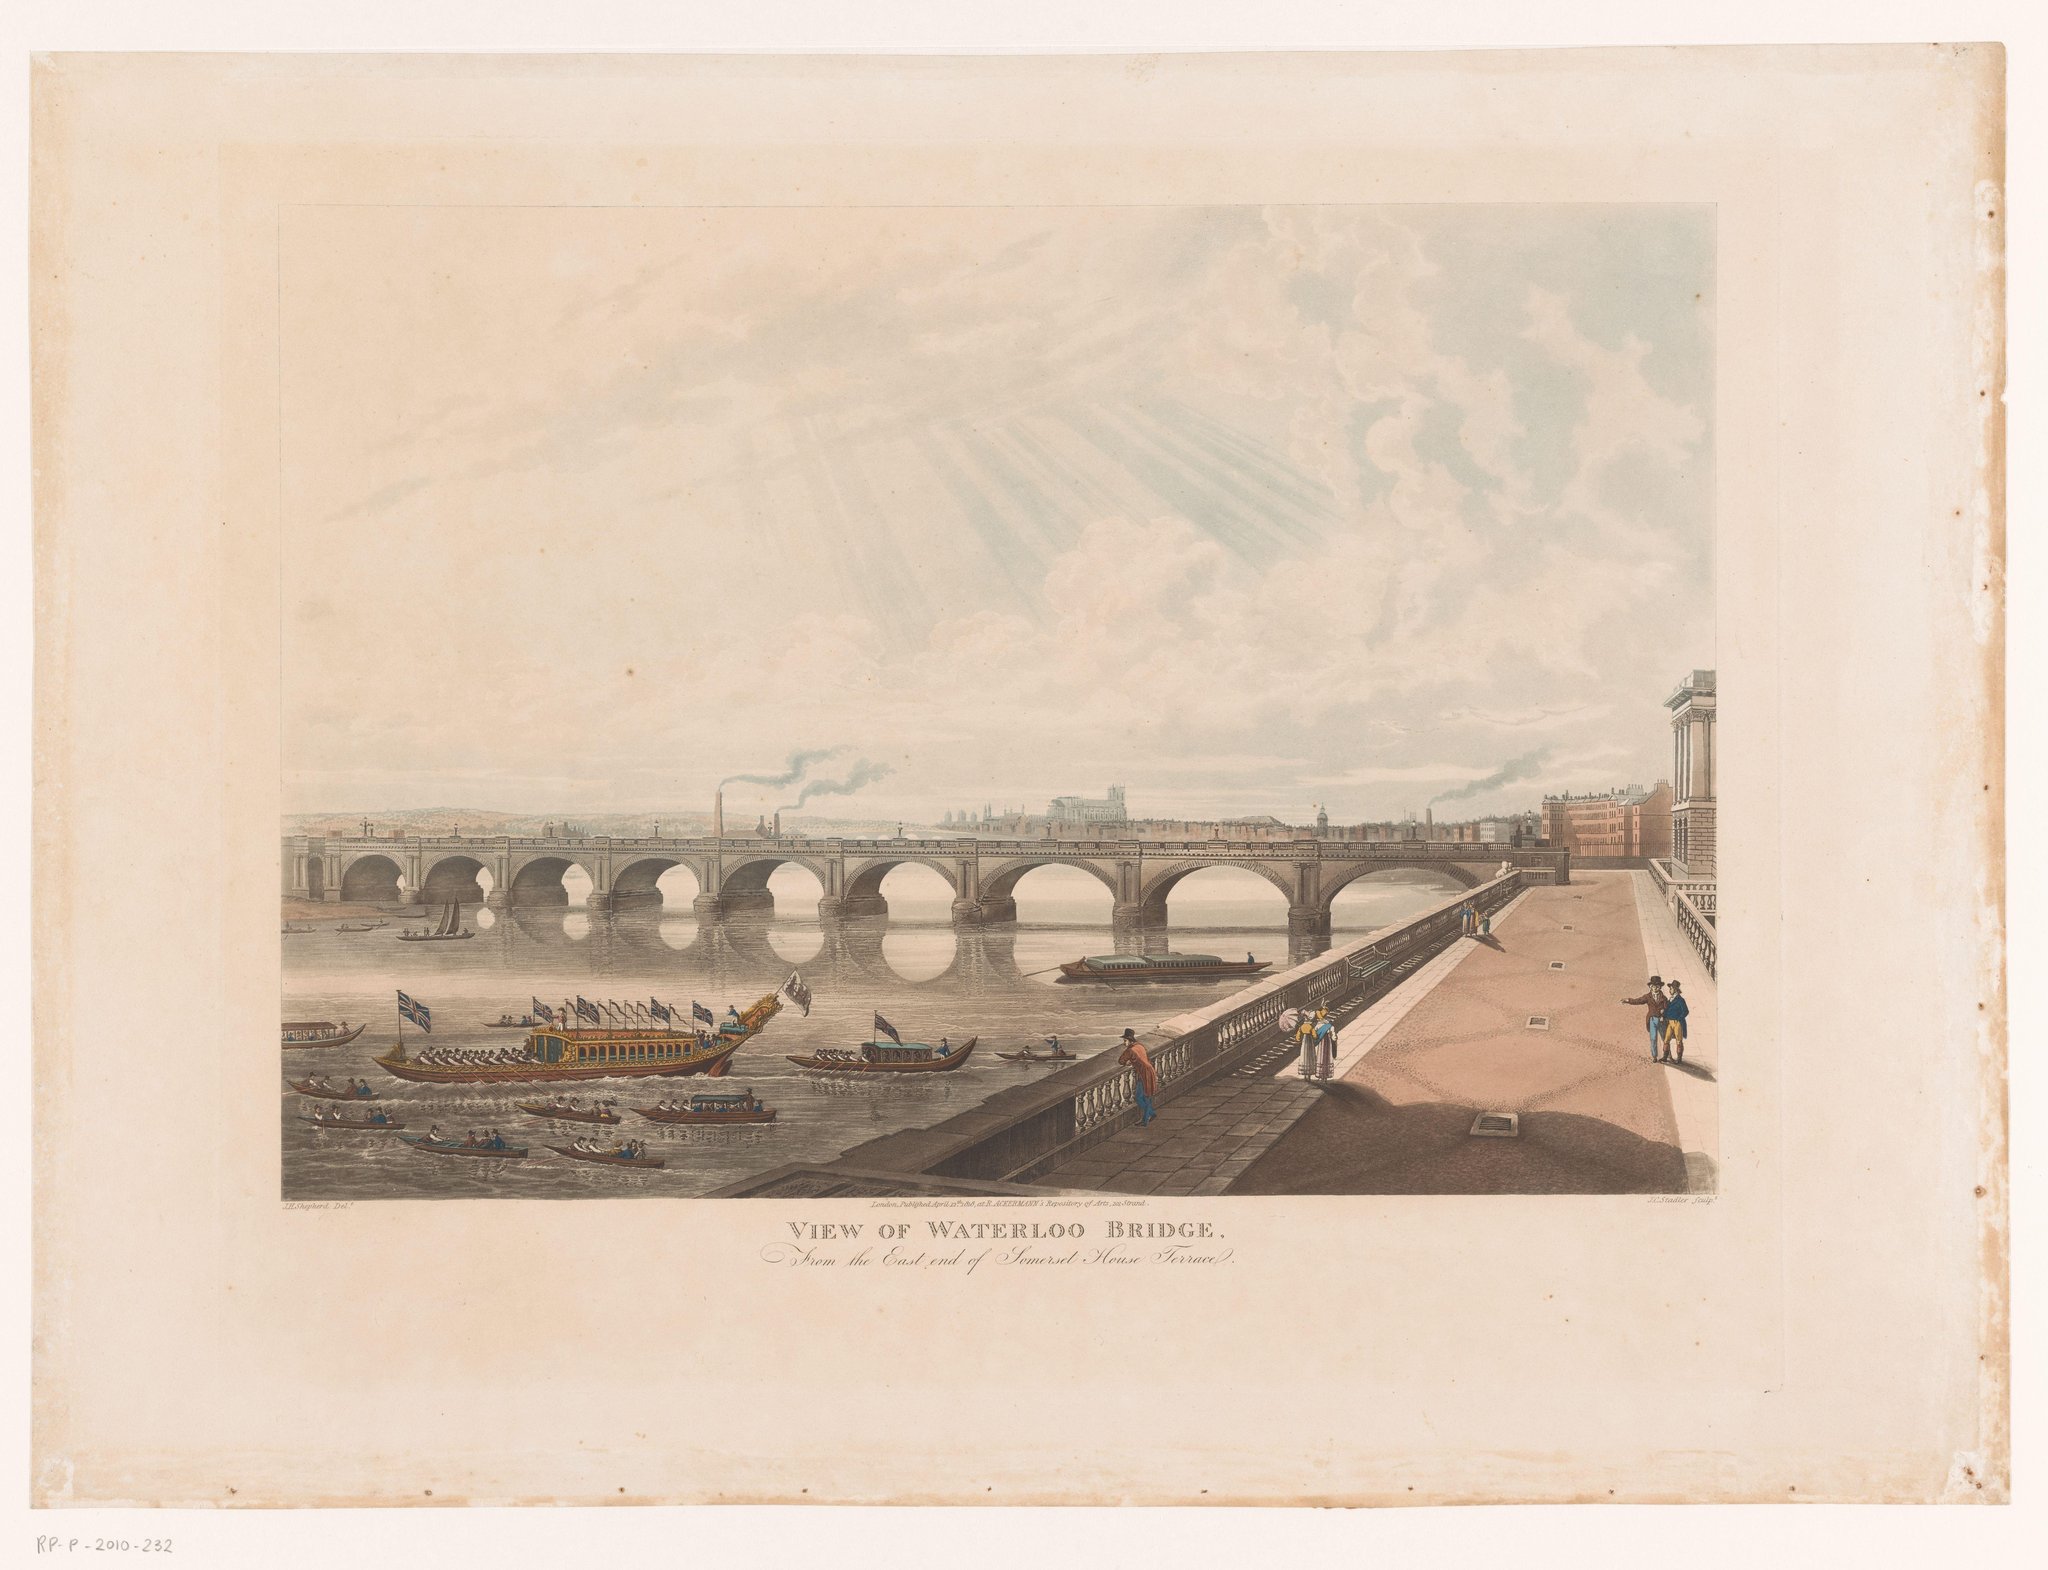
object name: print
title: Gezicht op de Waterloo Bridge vanaf de oostzijde van het terras van Somerset House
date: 1818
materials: ink, paper, watercolor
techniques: aquatint, etching, hand coloring, lithography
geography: london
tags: landscape with bridge, viaduct or aqueduct (+ city(-scape) with figures, staffage), trireme, galley, london, thames